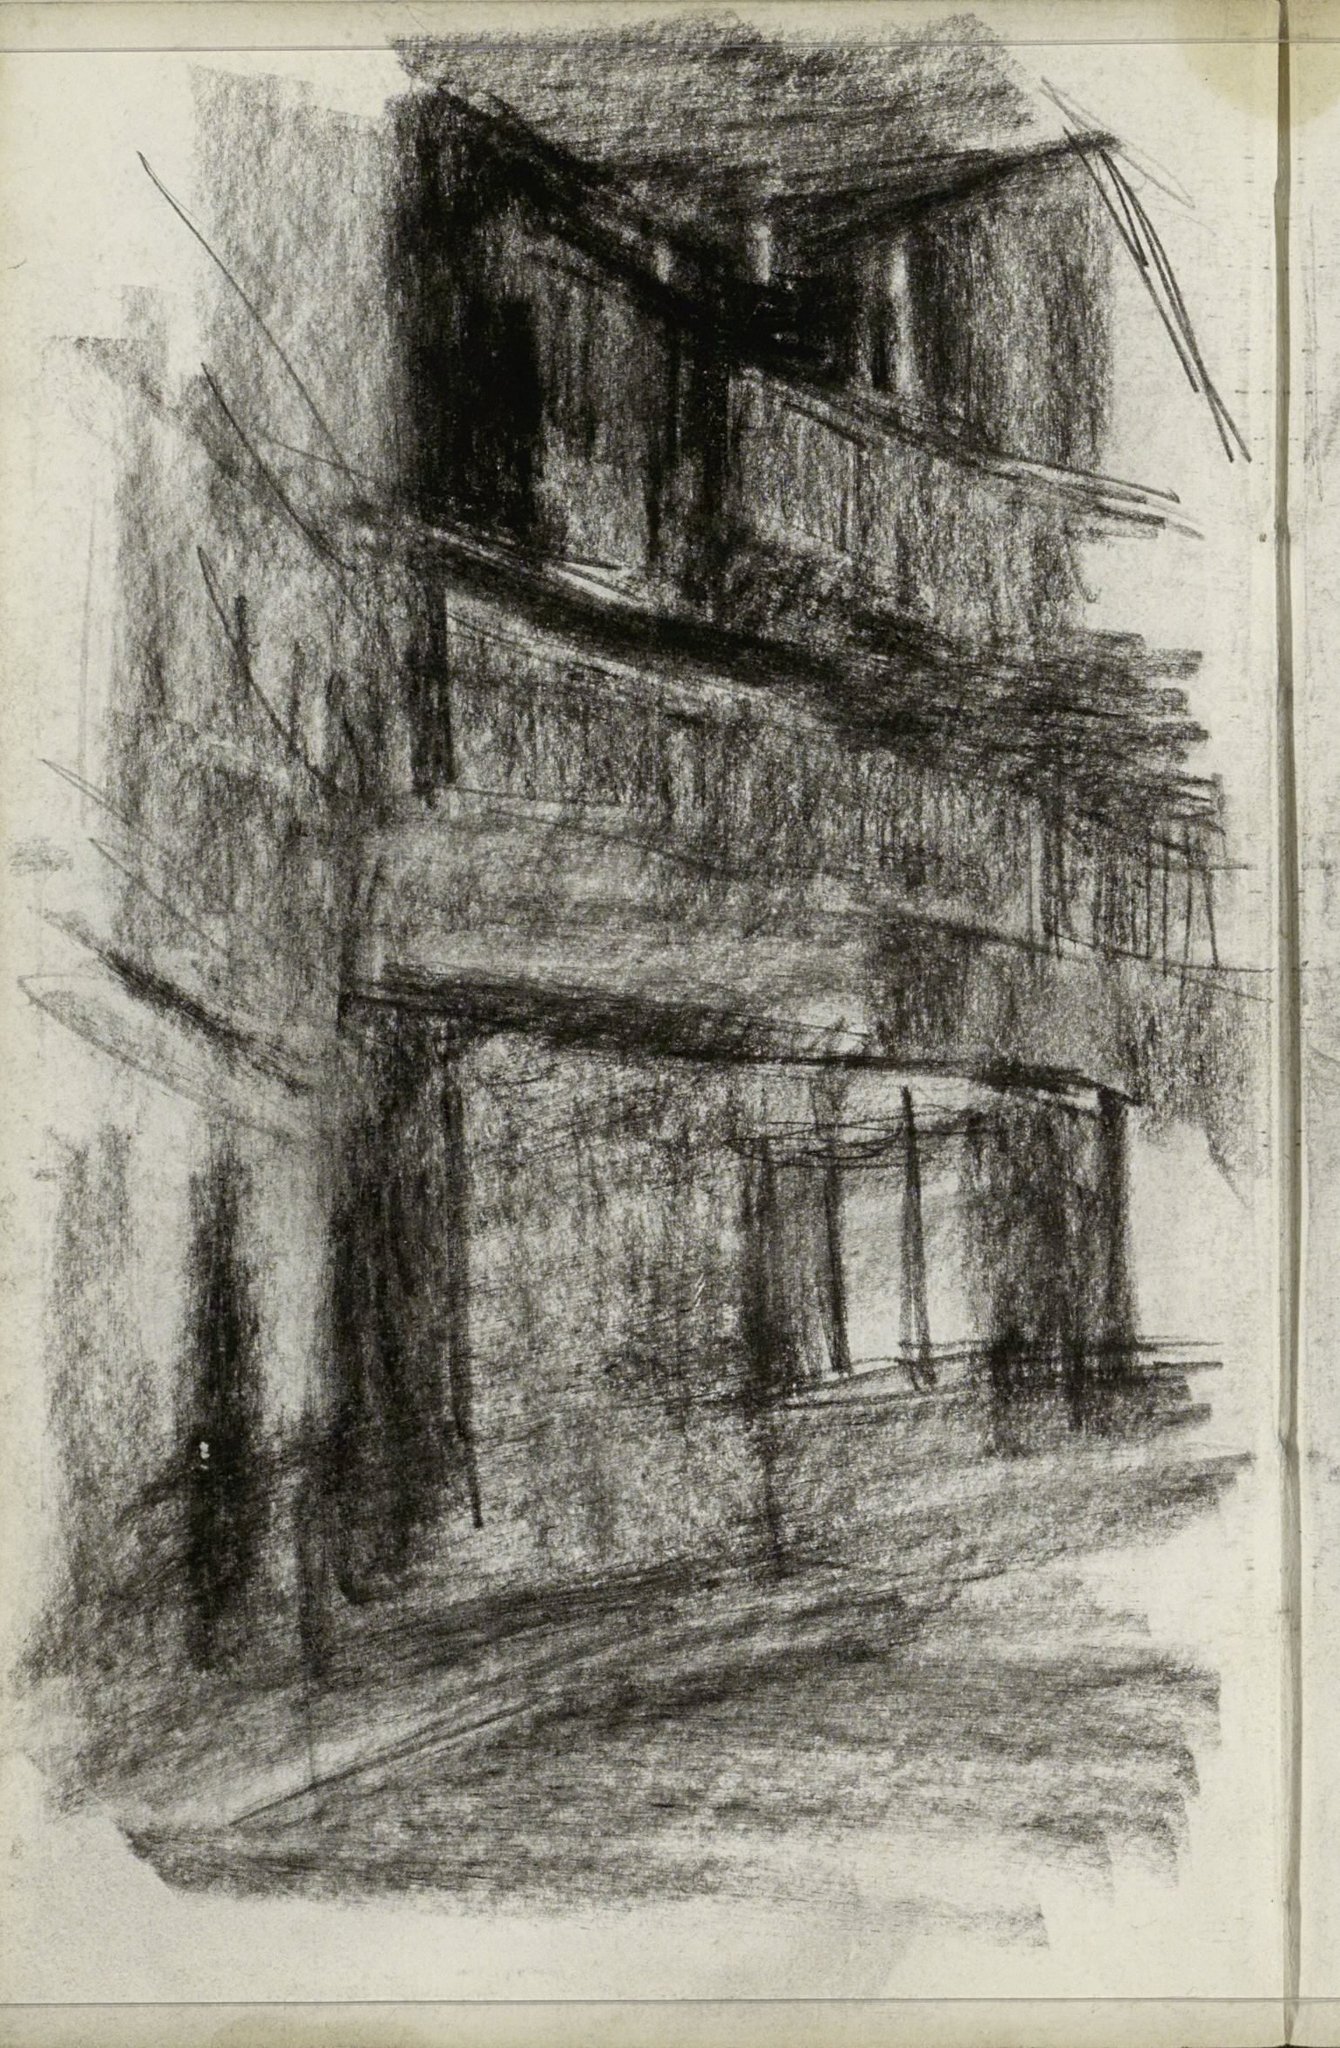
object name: sketchbook leaf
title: Gebouw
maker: isaac israels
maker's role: draughtsman, painter, print maker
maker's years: 1865-1934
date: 1875-1934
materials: chalk, paper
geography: london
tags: civic architecture; edifices; dwellings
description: Pagina 21 en pagina 22 uit schetsboek XXXV met 36 pagina's.